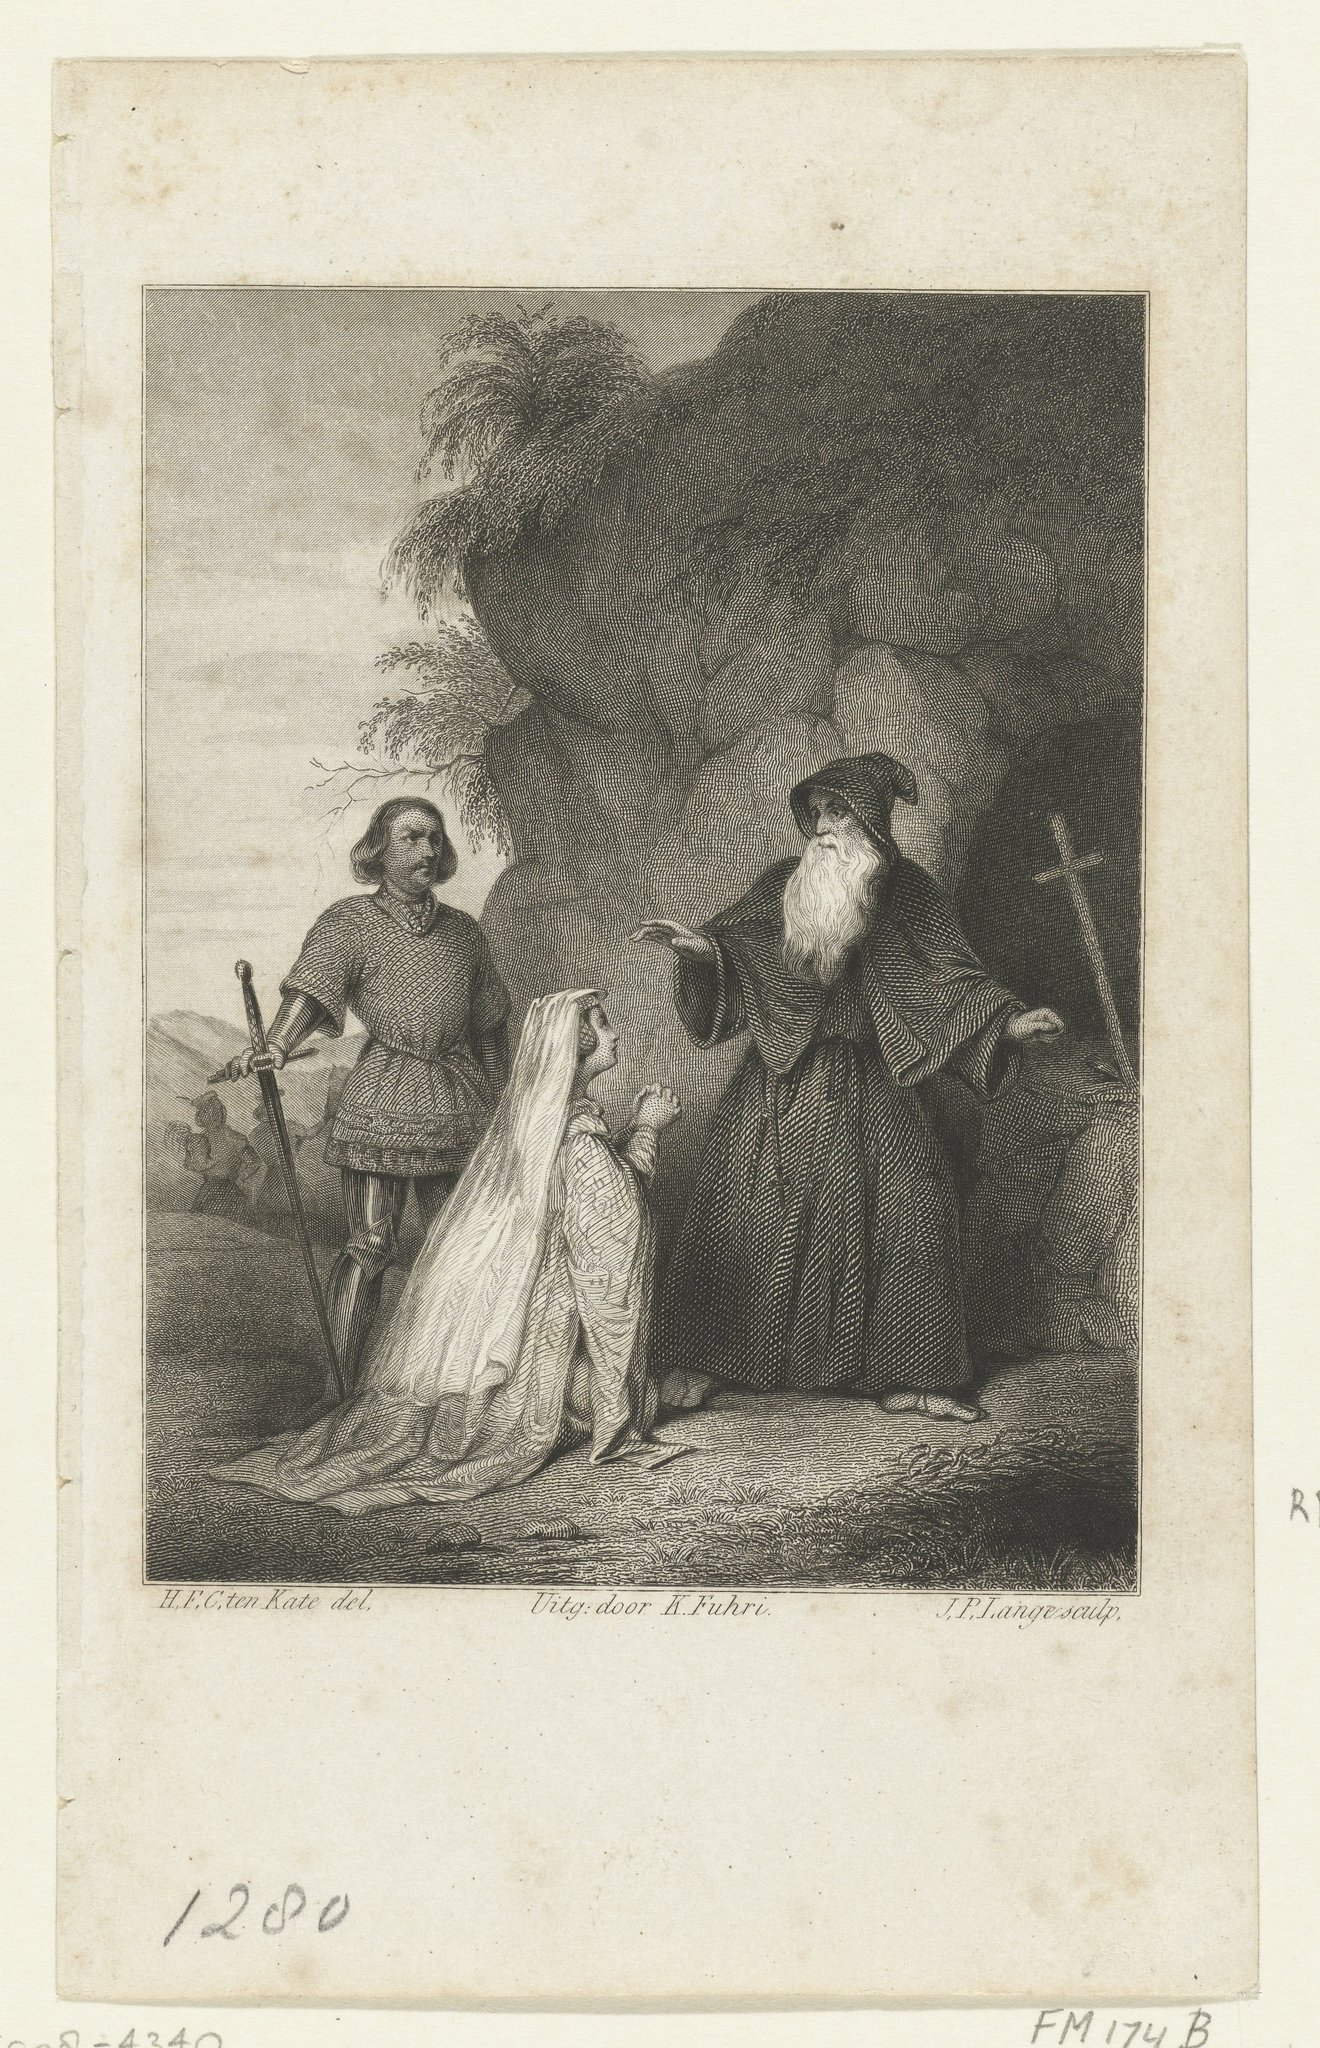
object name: history print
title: Agnes van der Sluis en Witte van Haemstede bij de priester, ca. 1300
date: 1820-1849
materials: paper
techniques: engraving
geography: netherlands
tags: netherlands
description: Witte van Haemstede met een vrouw bij een kluizenaar. De voorstelling is moeilijk exact te interpreteren. Volgens de oude gegevens bij deze prent zou het moment zijn voorgesteld dat Agnes van der Sluis en met haar zoon Witte van Haemstede de priester bezoekt die destijds graaf Floris V en haar had gezegend in 1280. Witte van Haemstede zou de zoon uit het later ontbonden huwelijk van Agnes van der Sluis en graaf Floris V zijn. Witte van Haemstede is echter ca. 1280-82 geboren en de moeder van Witte heette Aleid (of Anna) van Heusden, Agnes van der Sluis was de vrouw waarmee Witte in 1307 was getrouwd. Prentje uit de almanak Aurora.